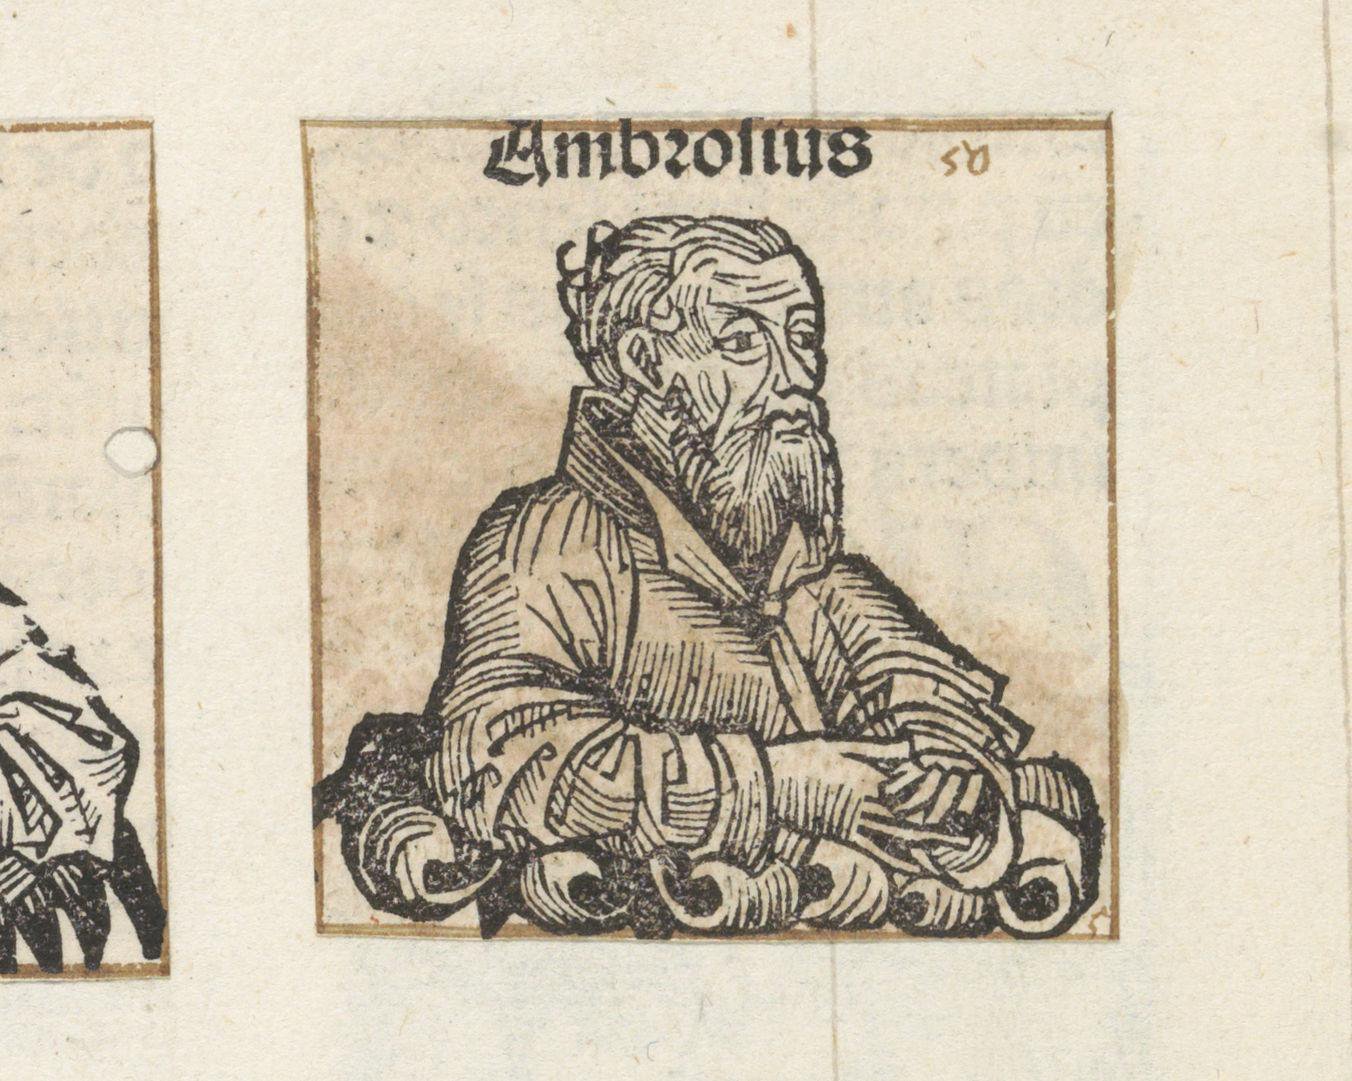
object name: book illustration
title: Ambrosius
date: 1493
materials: paper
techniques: letterpress printing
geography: nuremberg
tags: male persons from classical history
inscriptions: inscription: ‘50’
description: De houtsnede wordt herhaaldelijk gebruikt als boekillustratie in de Liber Chronicarum (of Neurenbergkroniek) van Hartmann Schedel, verschenen in het Latijn en Duits in 1493. Zie de Latijnse uitgave, folio 117v.